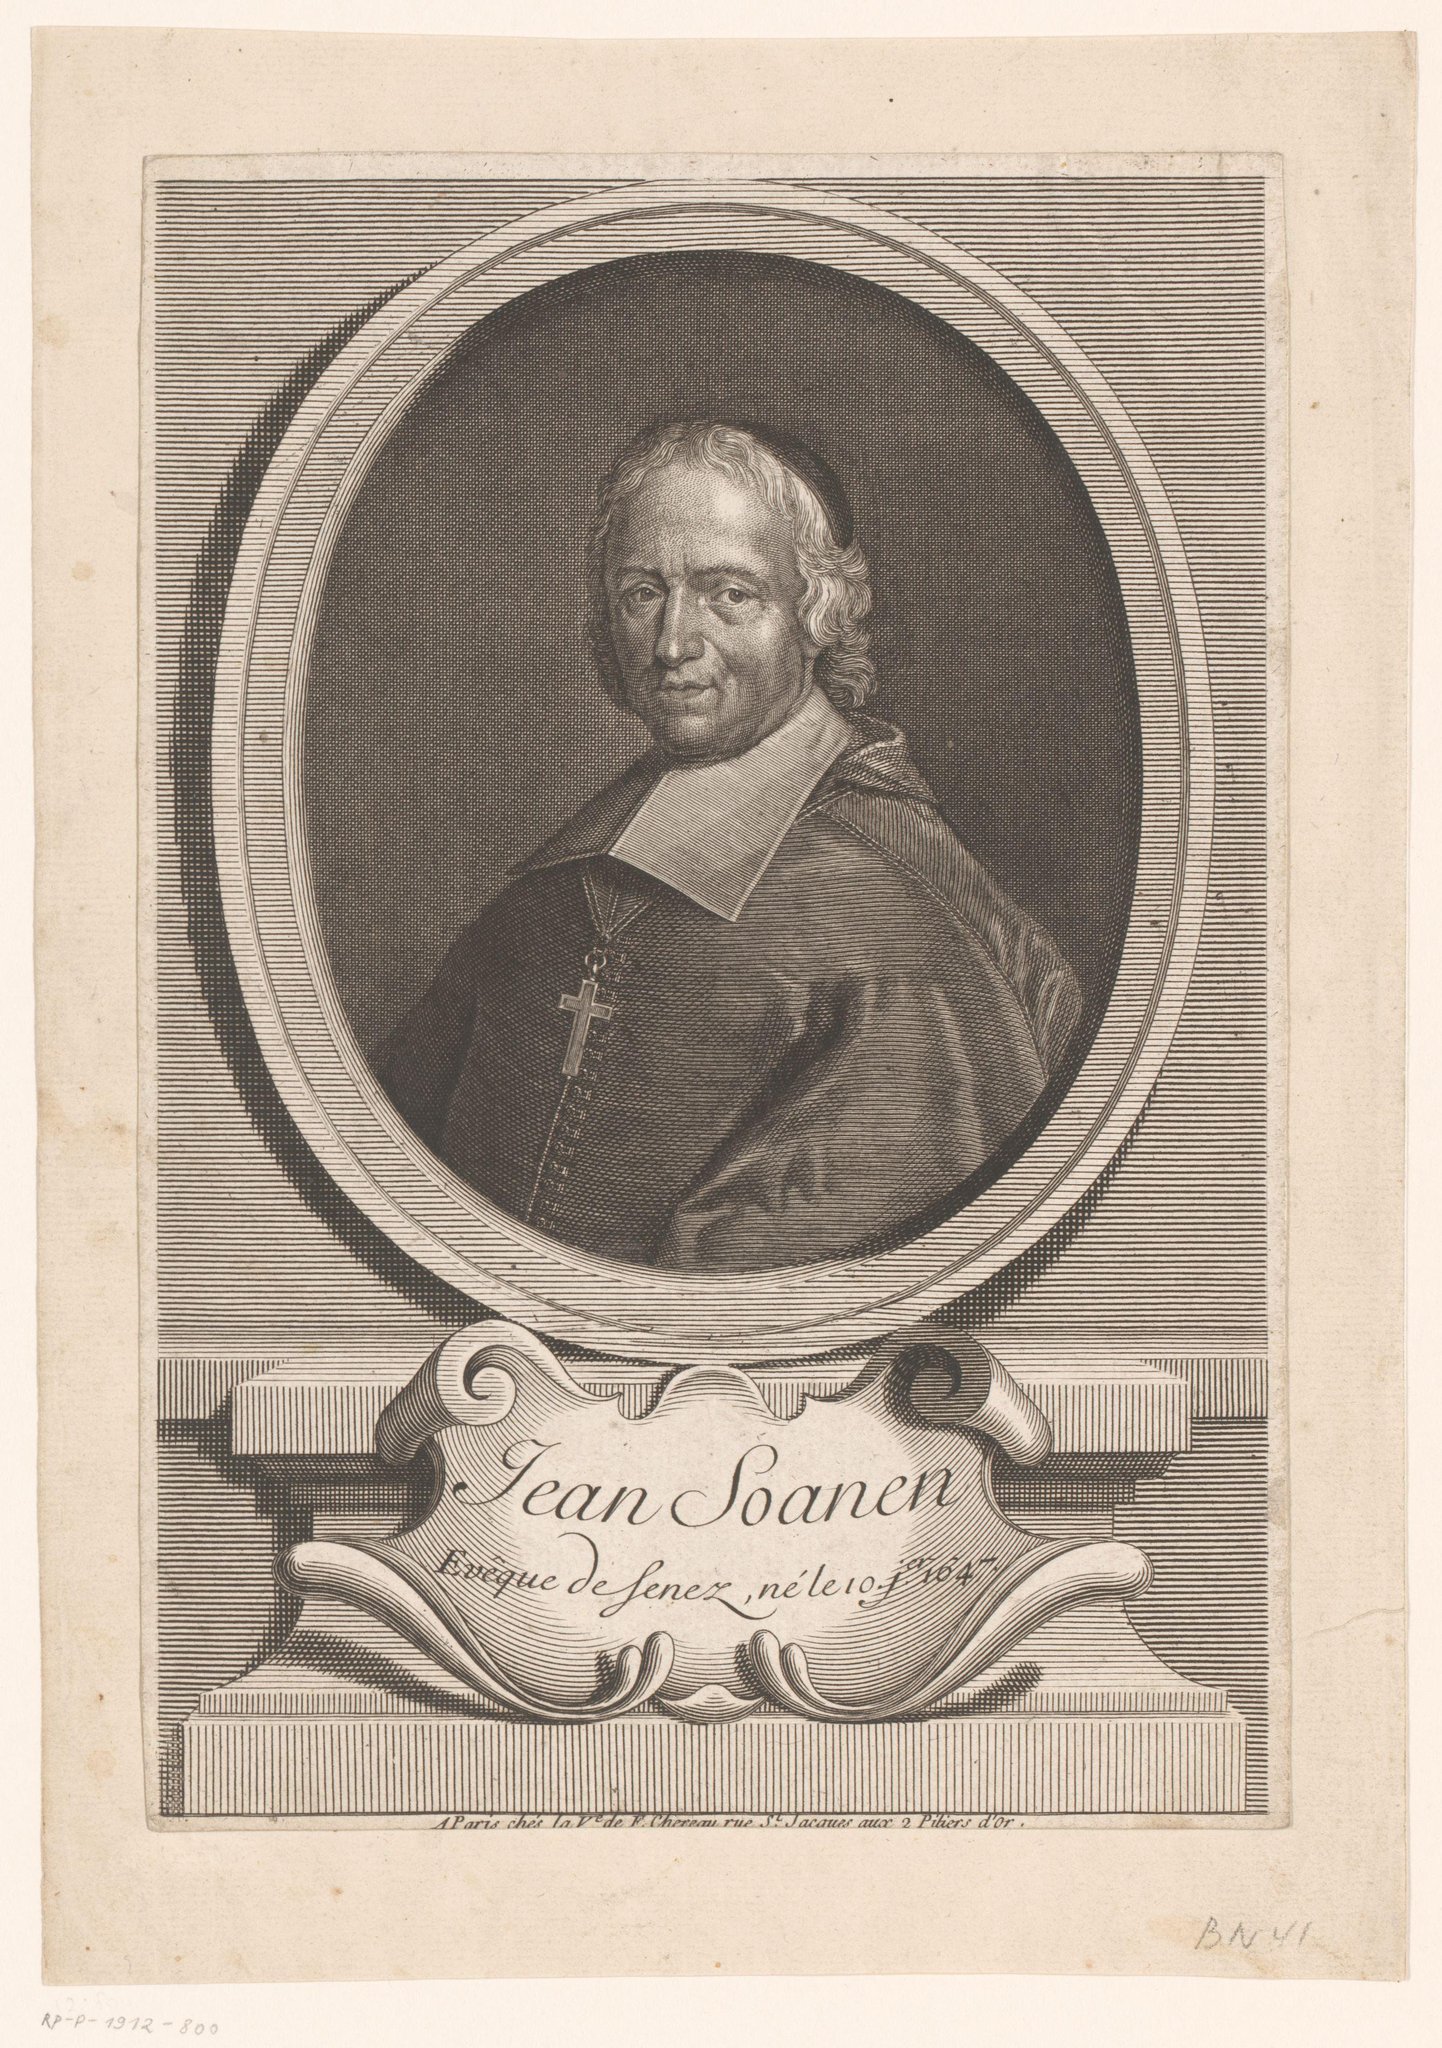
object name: print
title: Portret van Jean Soanen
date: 1698-1776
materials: paper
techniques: engraving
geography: france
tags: ornament ~ medallion, historical persons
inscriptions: collector's mark: Lugt 2228